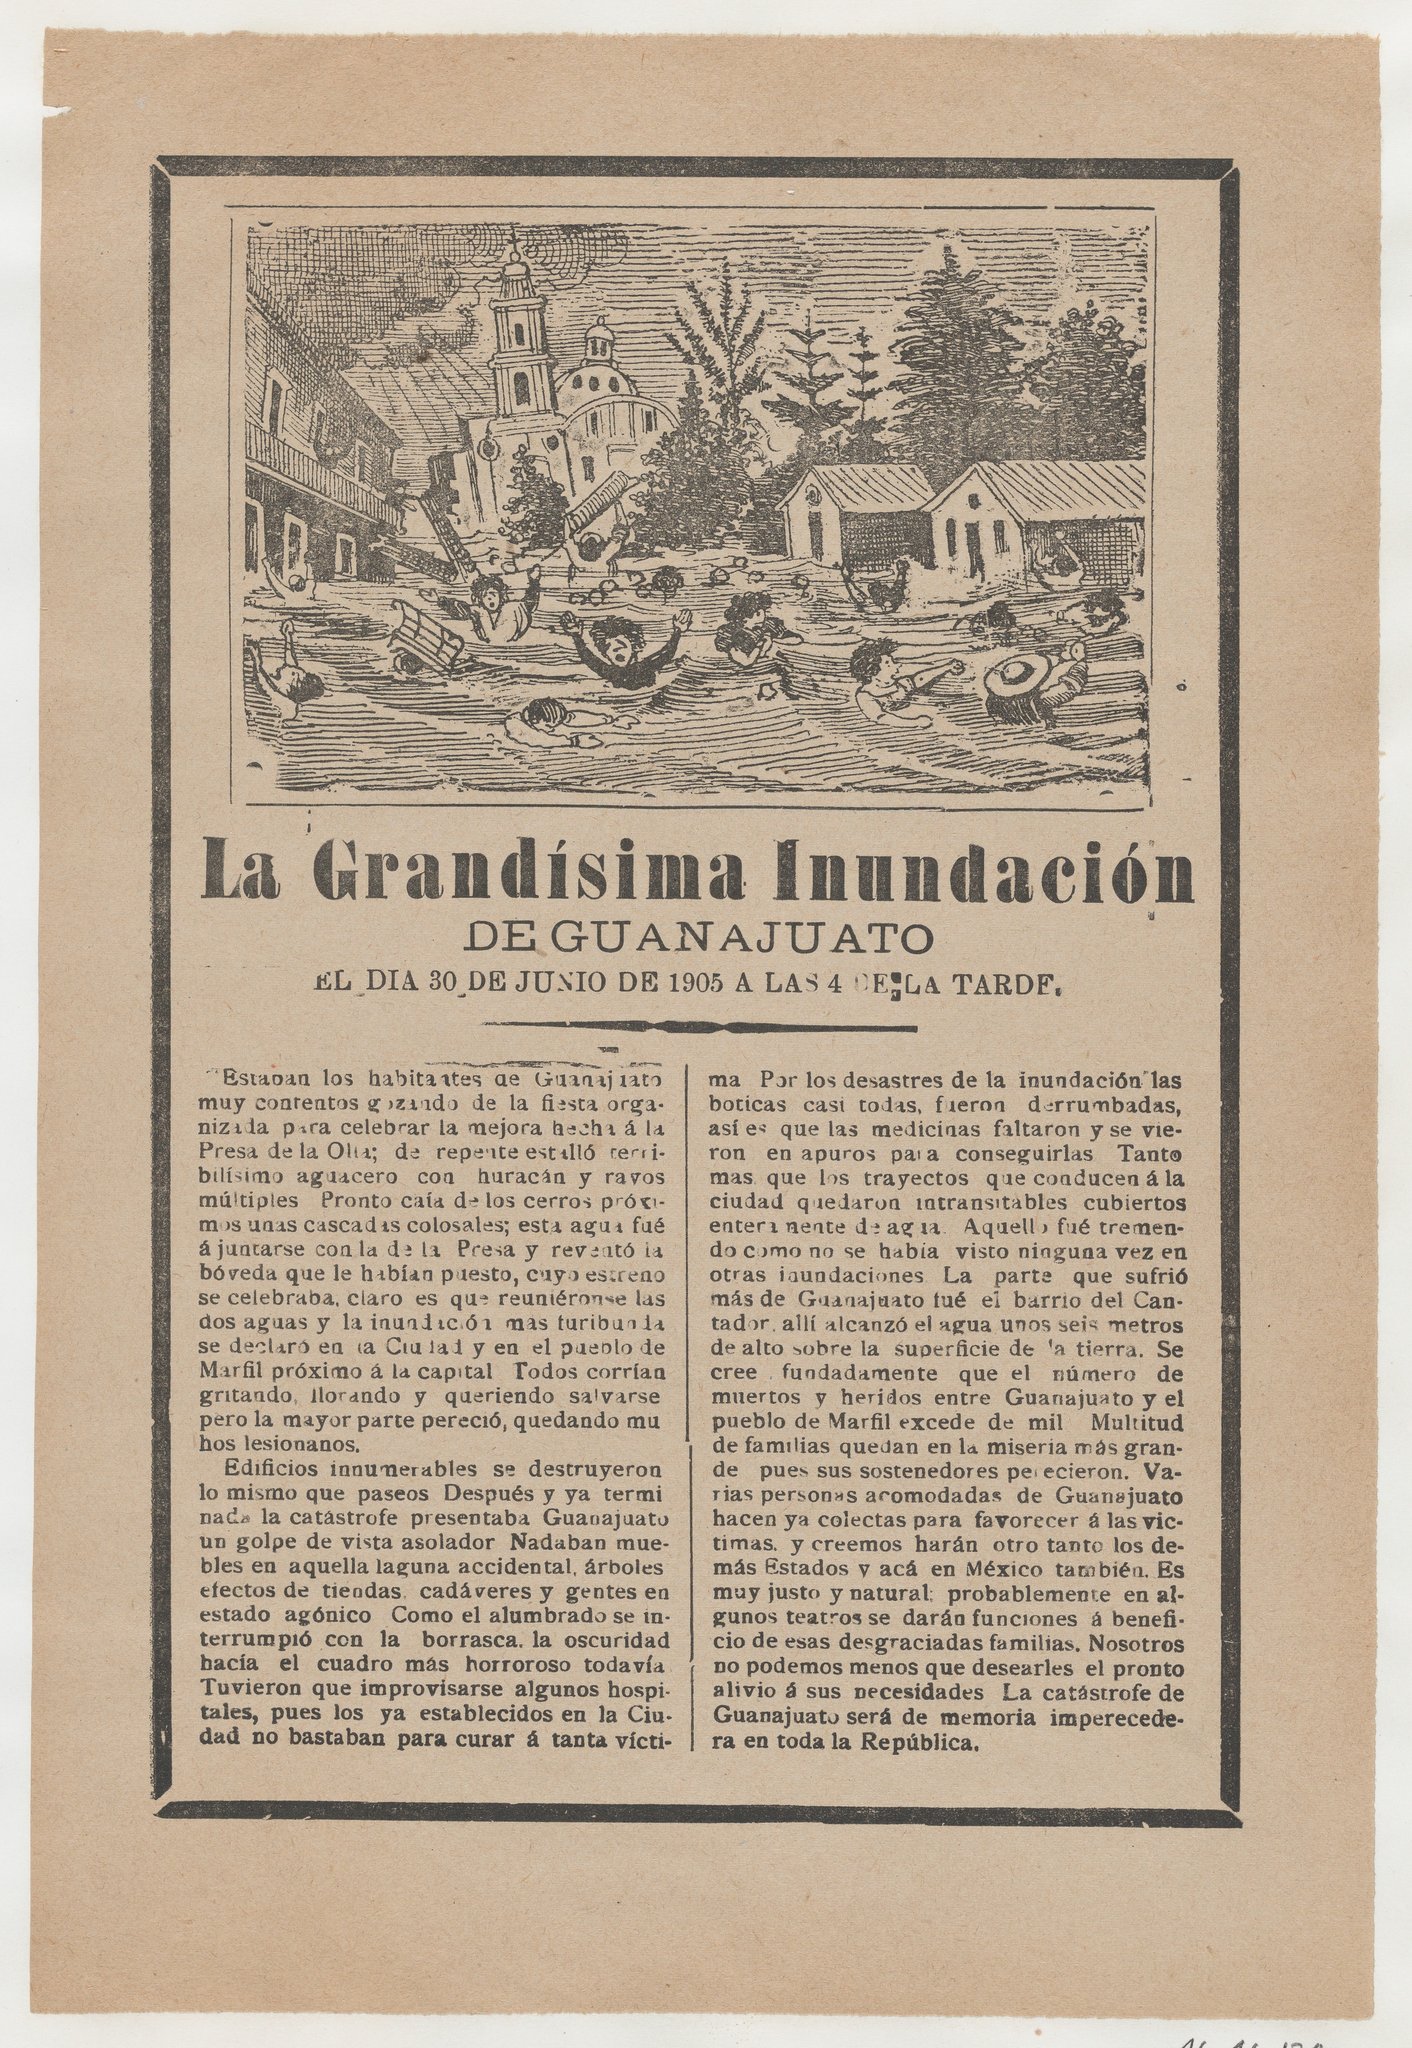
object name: print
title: Broadsheet relating to the great flood of Guanajuato on 30 June 1905, a description in the bottom section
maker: josé guadalupe posada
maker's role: artist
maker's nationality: mexican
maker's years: 1852-1913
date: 1905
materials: paper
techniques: letterpress, lithography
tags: floods